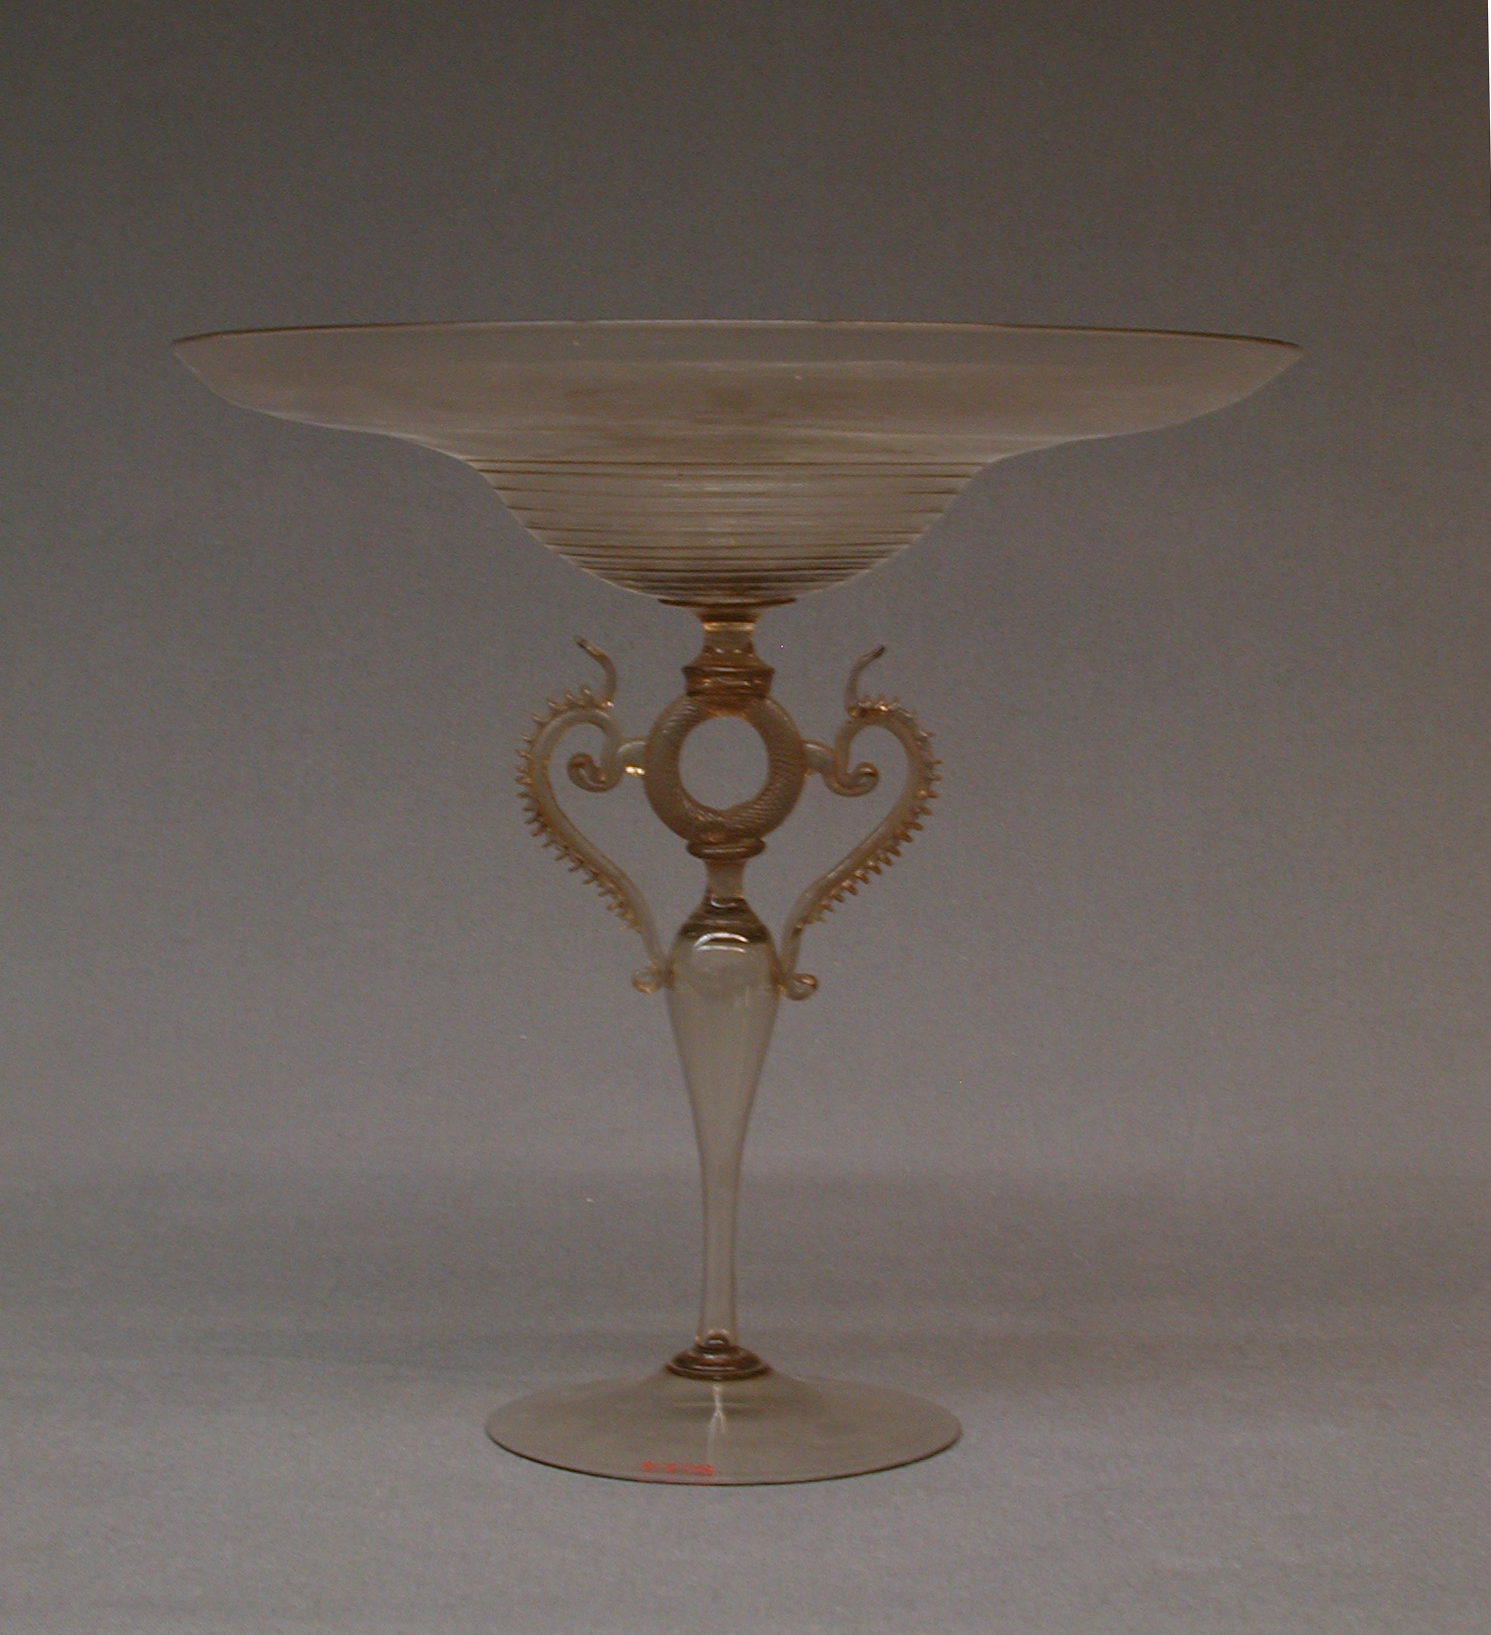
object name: tazza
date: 1801-1900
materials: glass